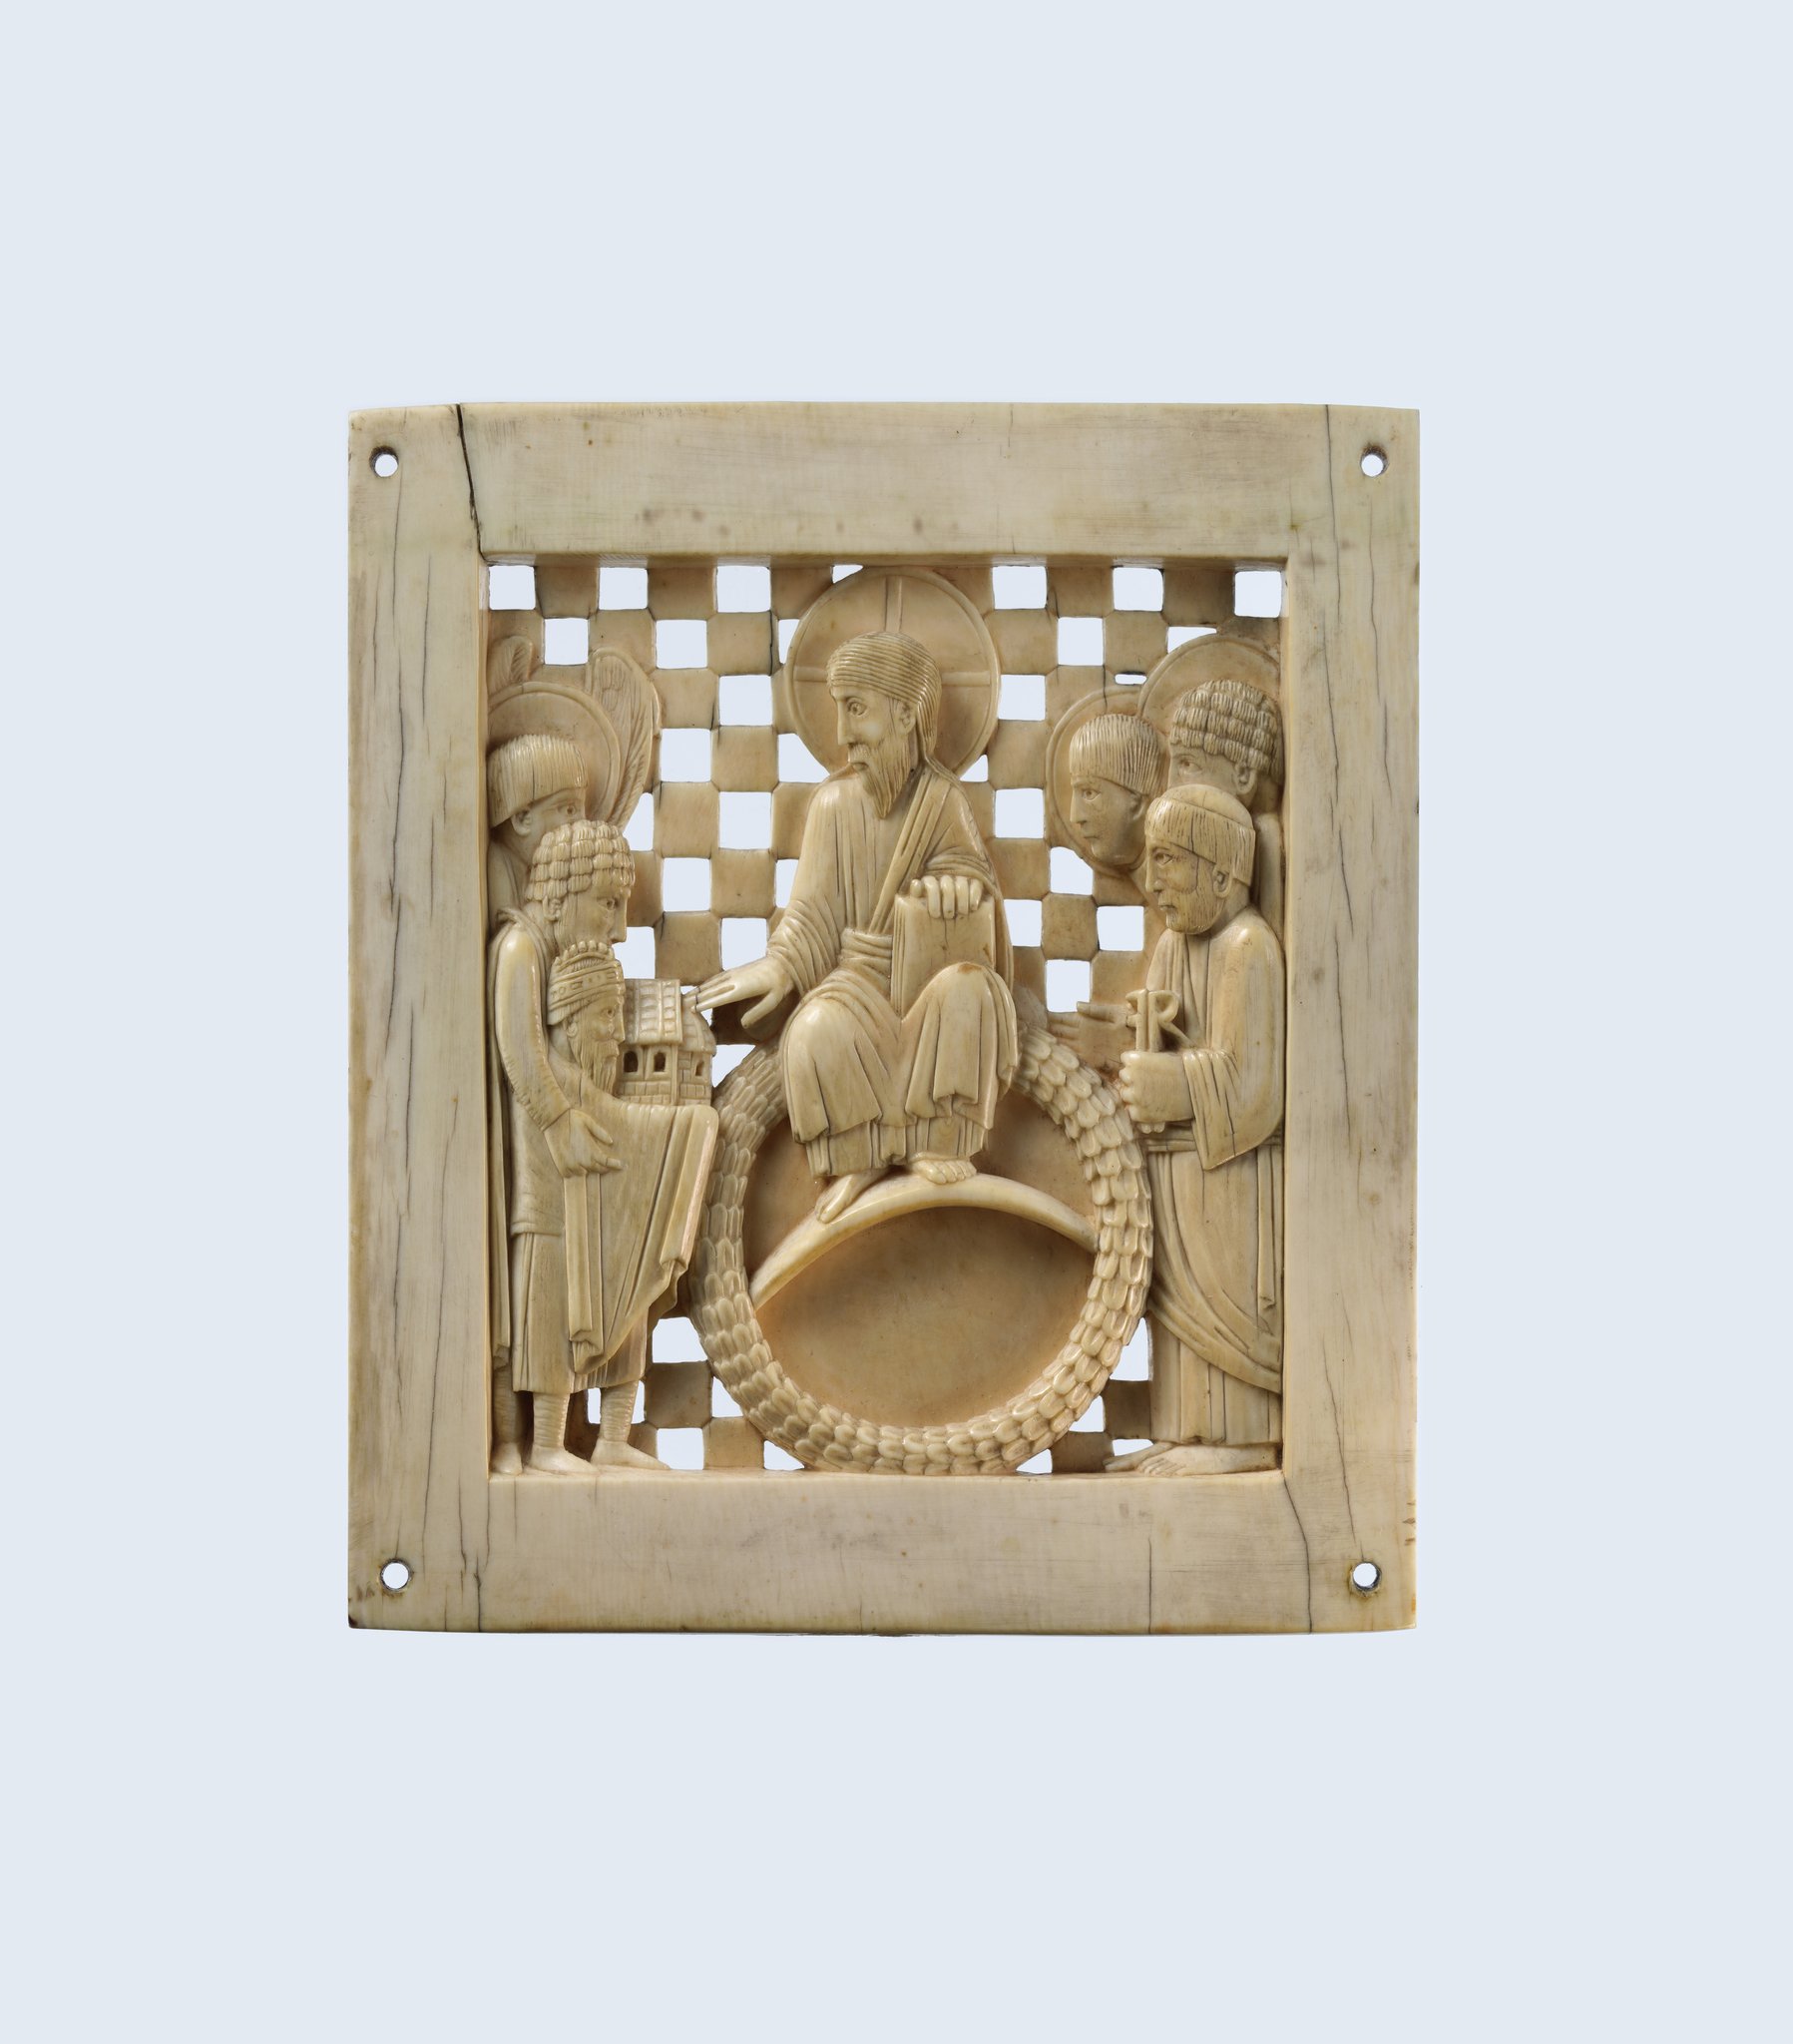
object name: plaque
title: Plaque with Christ Receiving Magdeburg Cathedral from Emperor Otto I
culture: ottonian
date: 962-968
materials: ivory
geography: milan (?)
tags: men,christ,saints